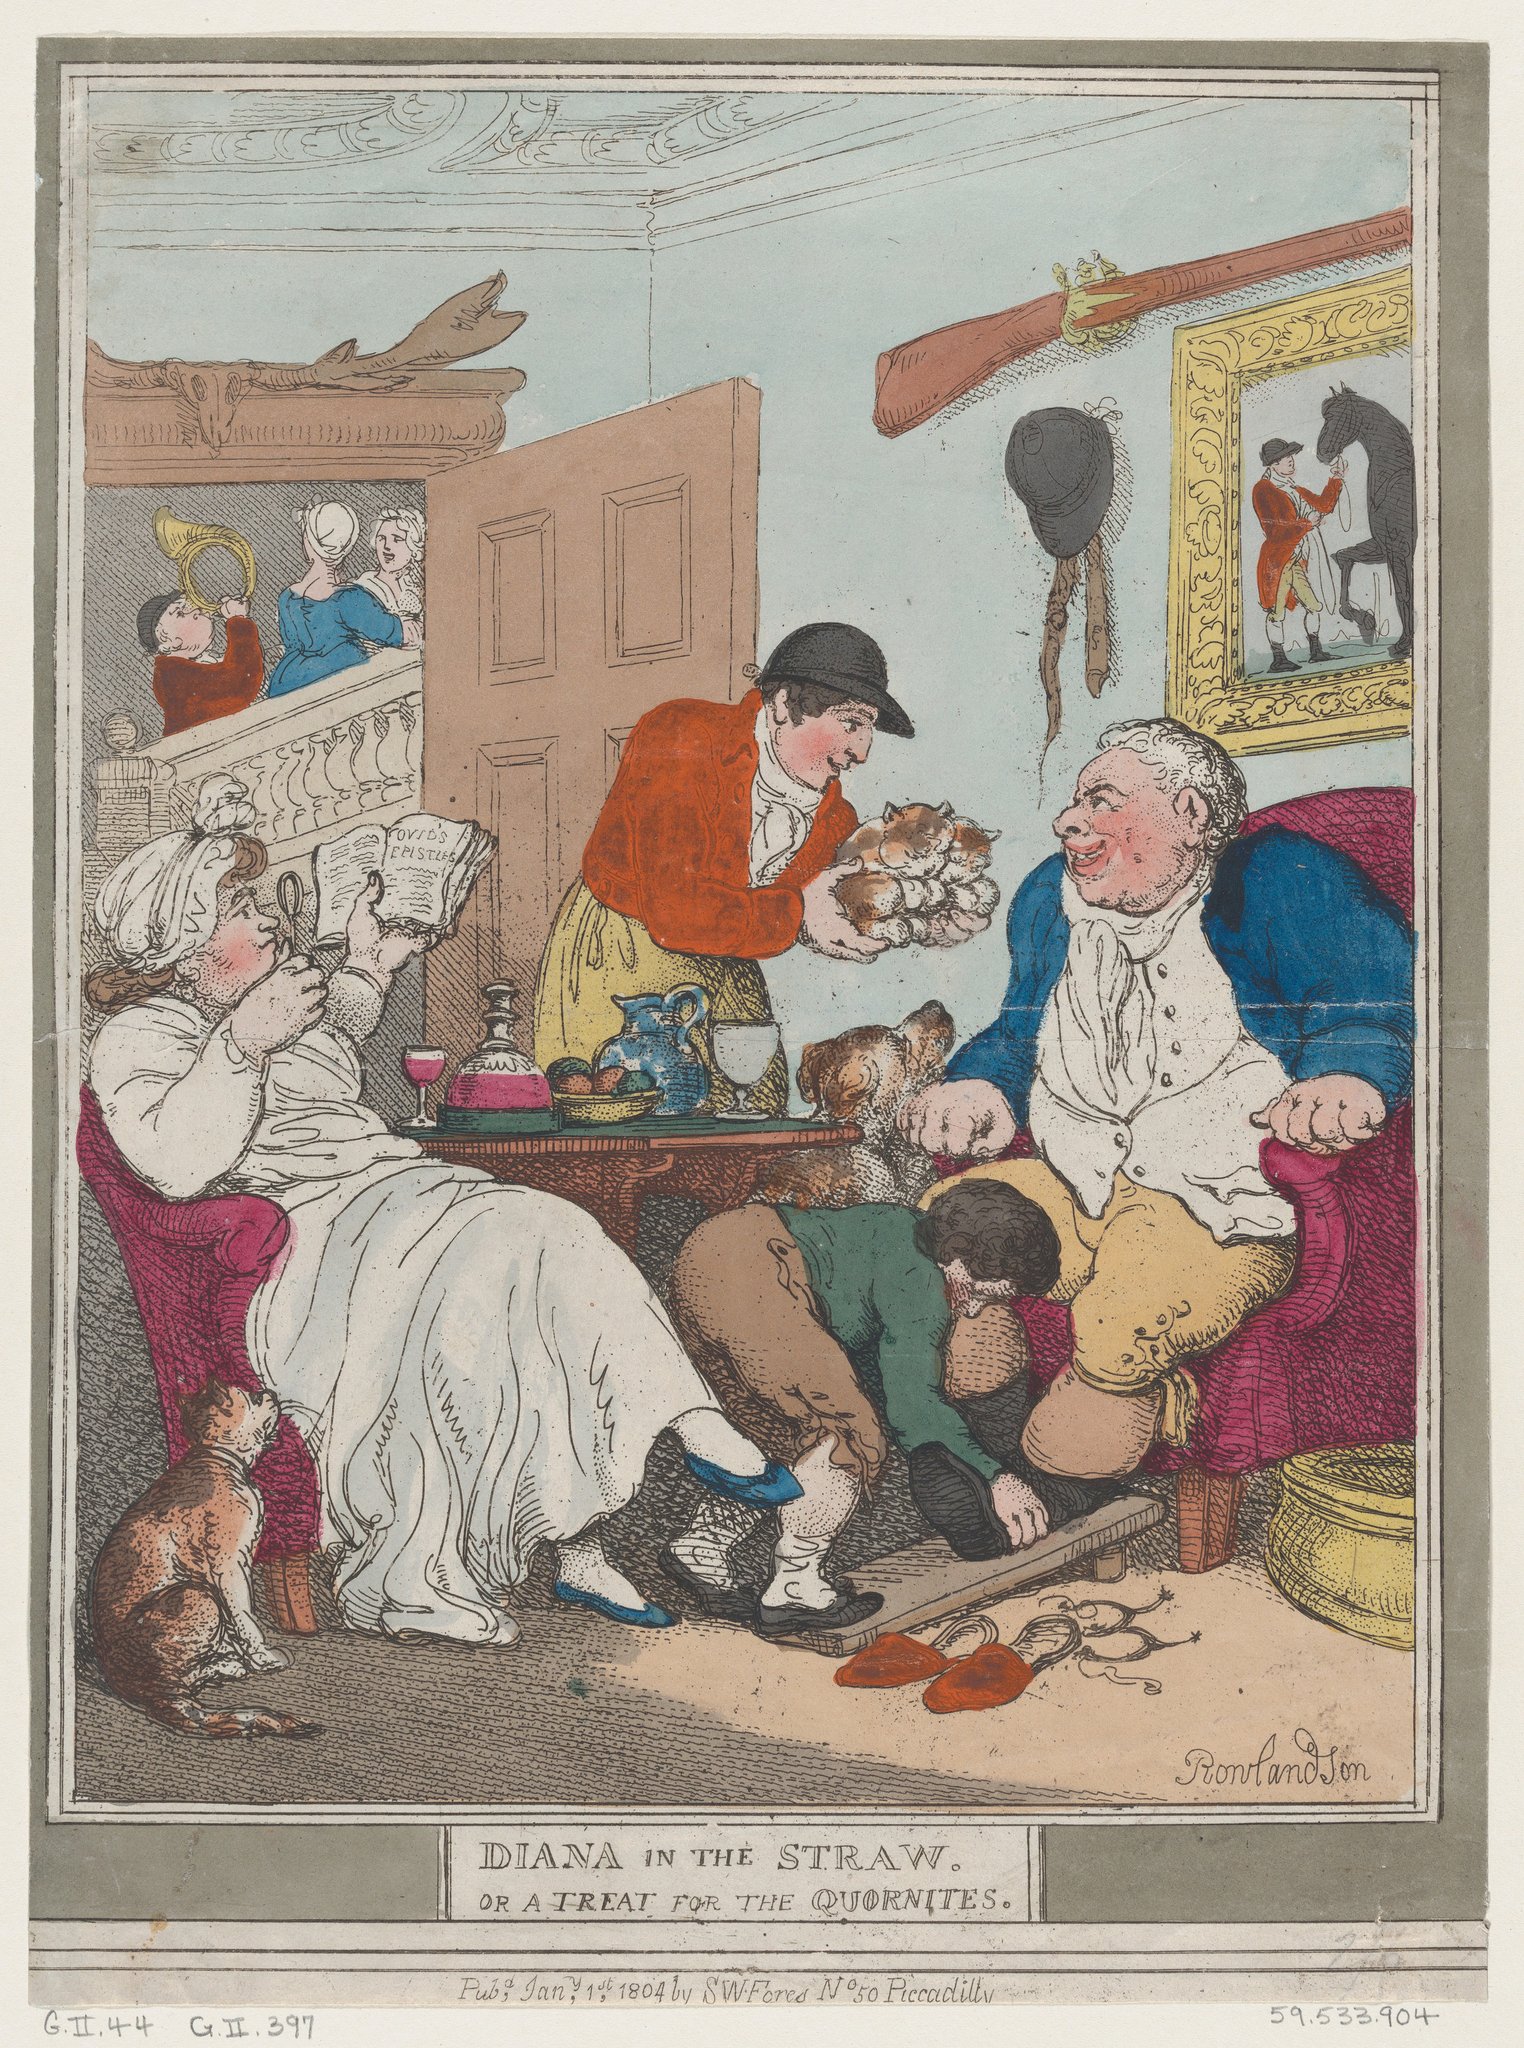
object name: print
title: Diana in the Straw, or A Treat for Quornites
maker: thomas rowlandson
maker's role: artist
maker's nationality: british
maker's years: 1757-1827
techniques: etching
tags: satire,men,women,cats,dogs